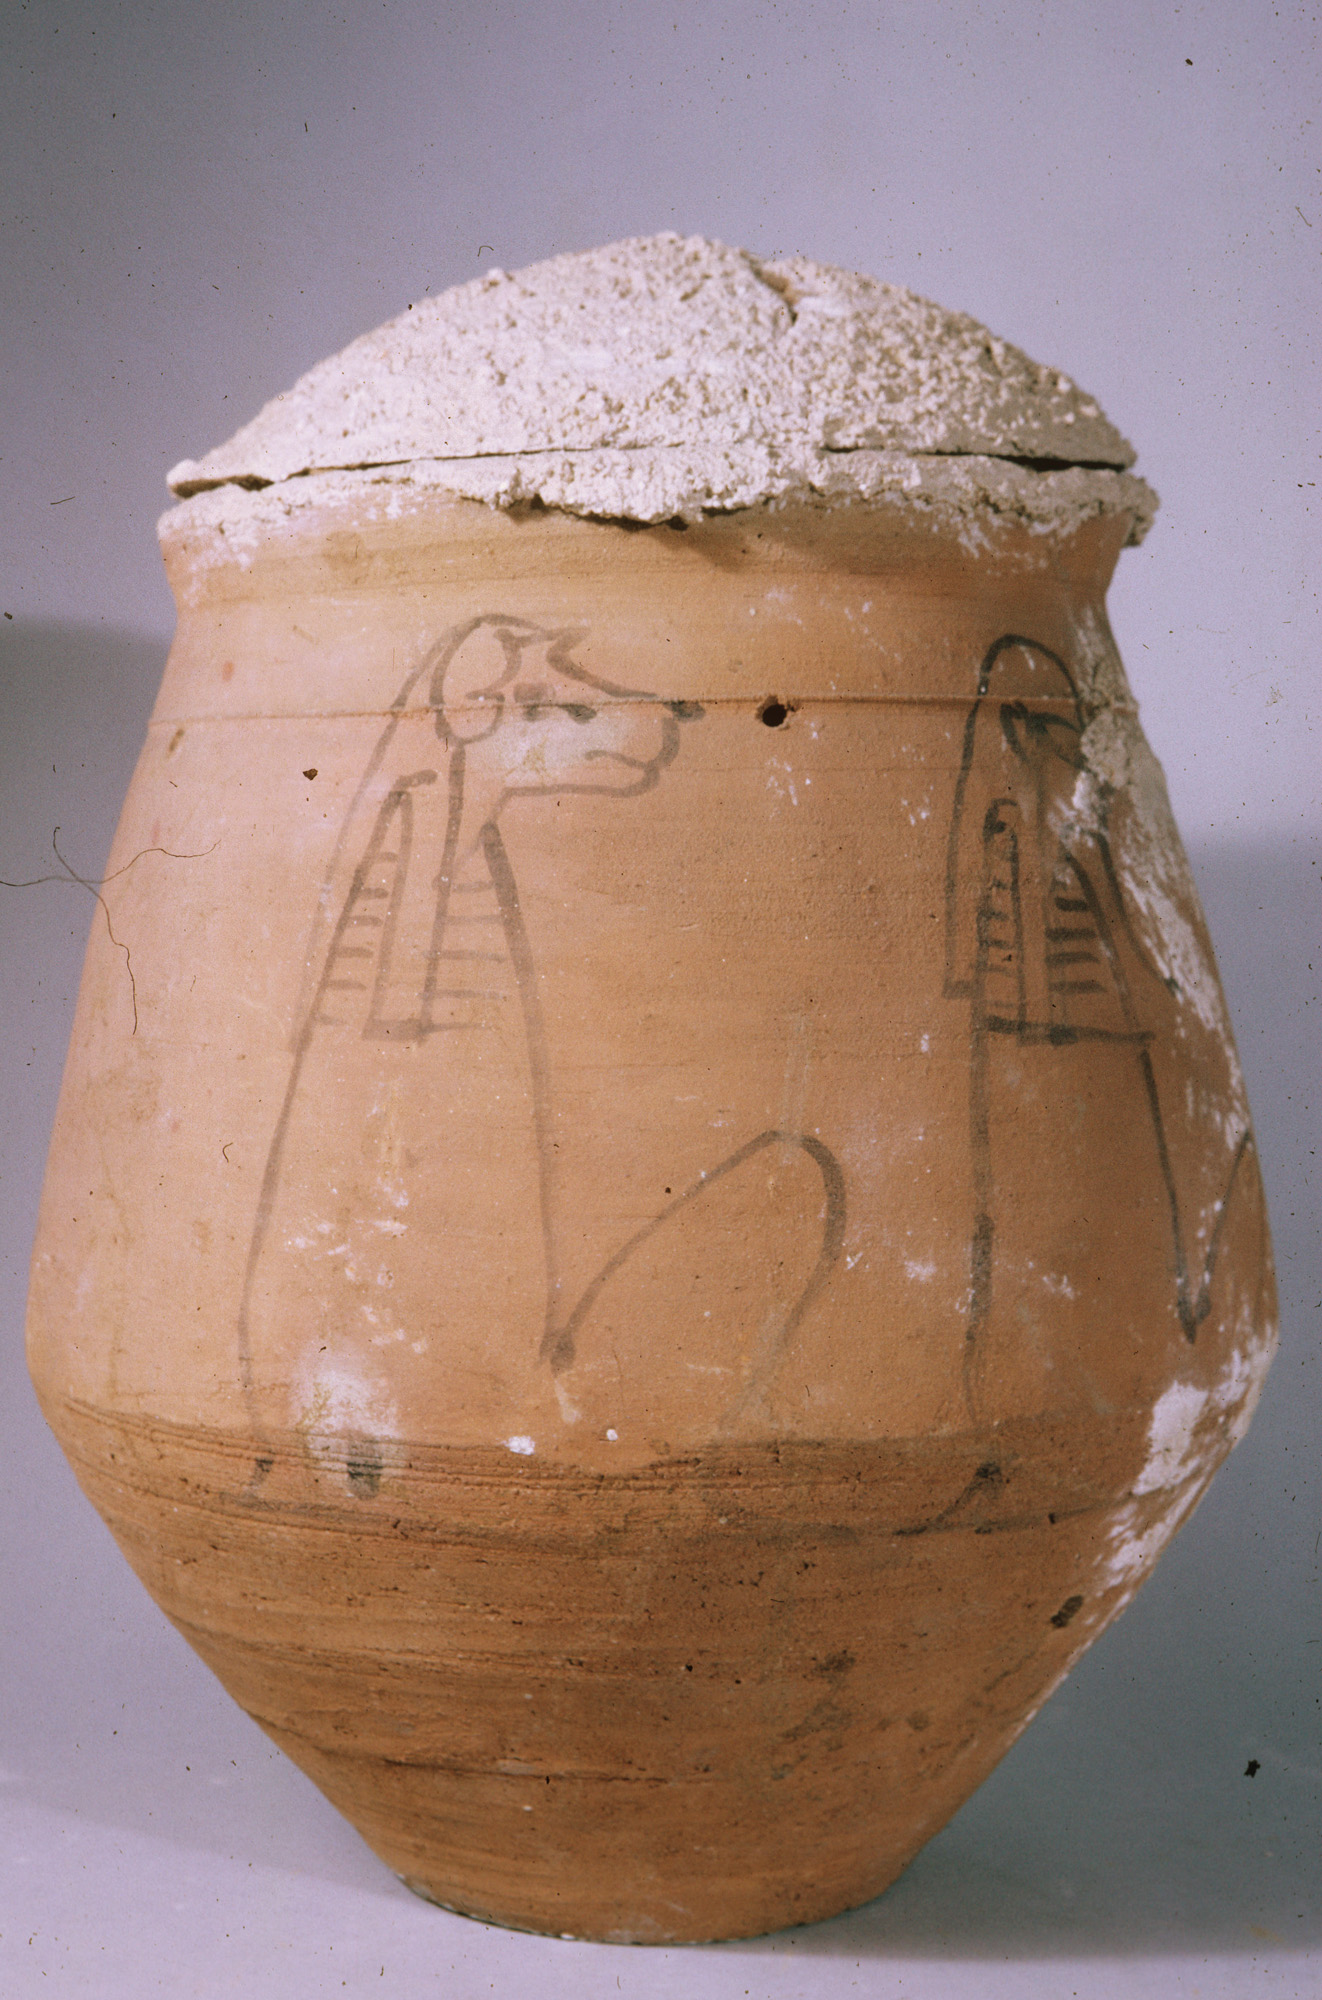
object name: jar, lid, painted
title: Jar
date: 1295-1070 BCE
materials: paint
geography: middle egypt